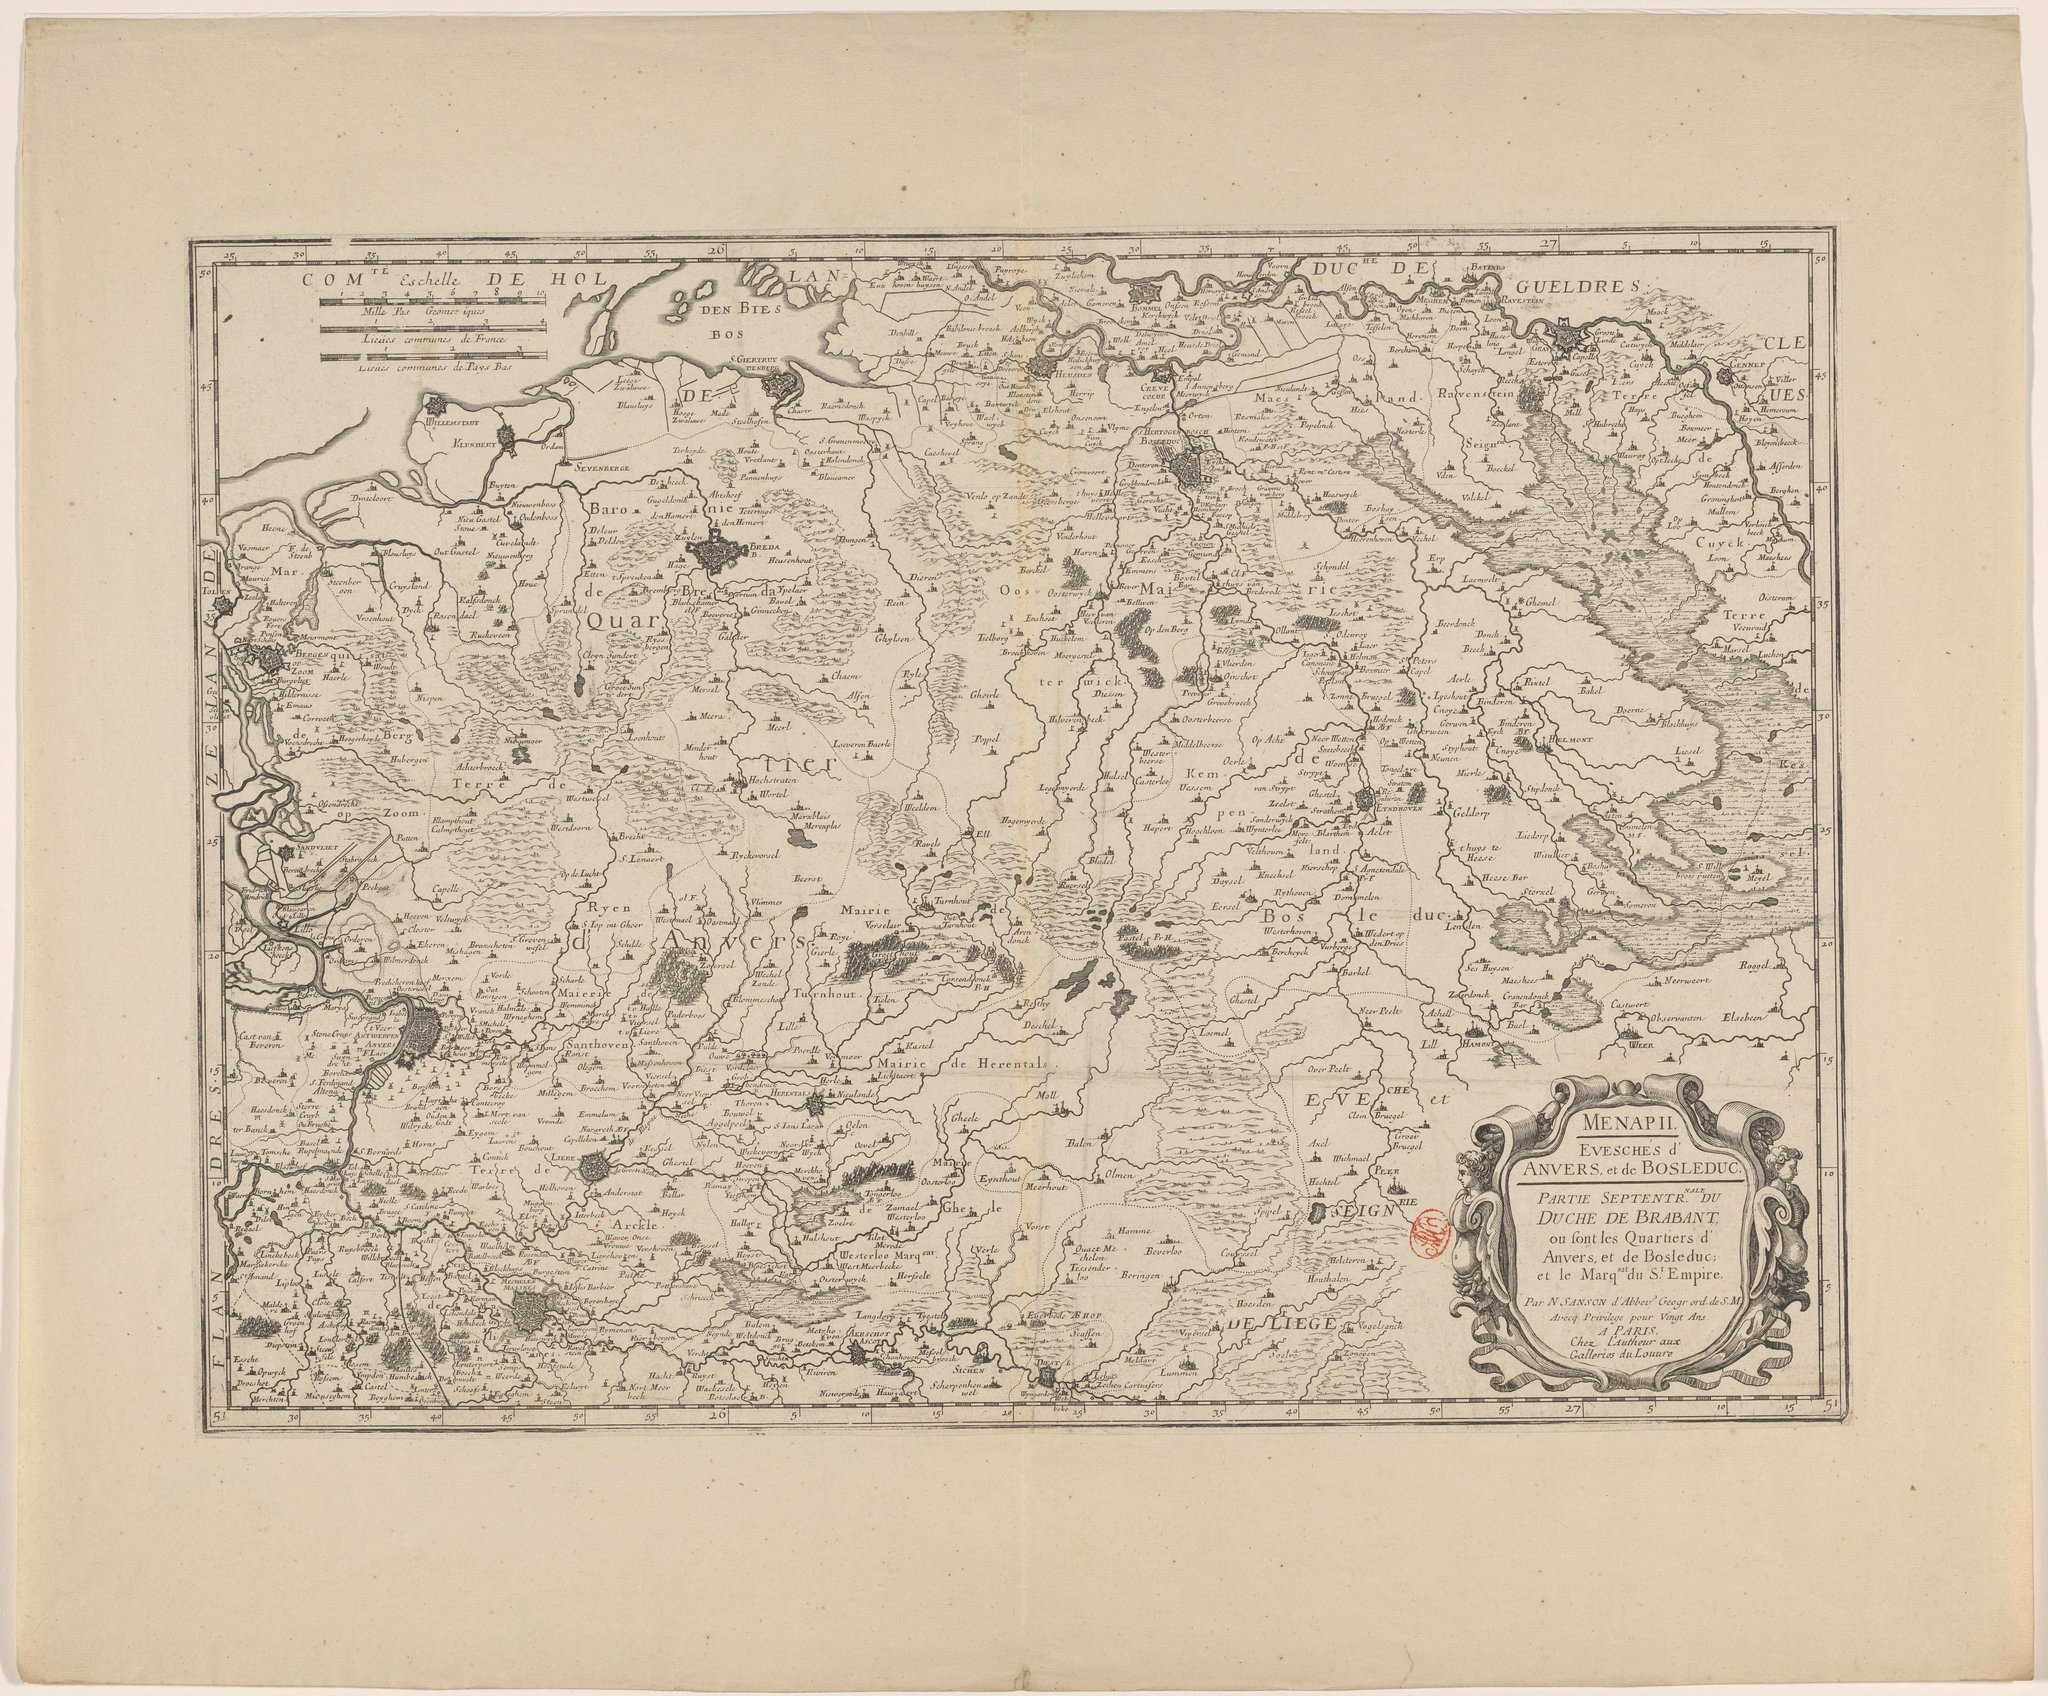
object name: map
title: Menapii. Eveschés d'Anvers, et de Bosleduc. Partie Septentr.nale du Duche de Brabant (...).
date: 1647-1667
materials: paper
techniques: engraving, etching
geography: paris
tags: maps of separate countries or regions, brabant, antwerp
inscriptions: collector's mark: Lugt 195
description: Kaart van een deel van het hertogdom Brabant. Rechtsonder de titelcartouche. Linksboven drie schaalstokken: 10 Mille Pas Geometriques / 4 Lieues communes de France / 3 Lieues communes de Pays Bas. De kaart is voorzien van een gradenverdeling langs de randen.